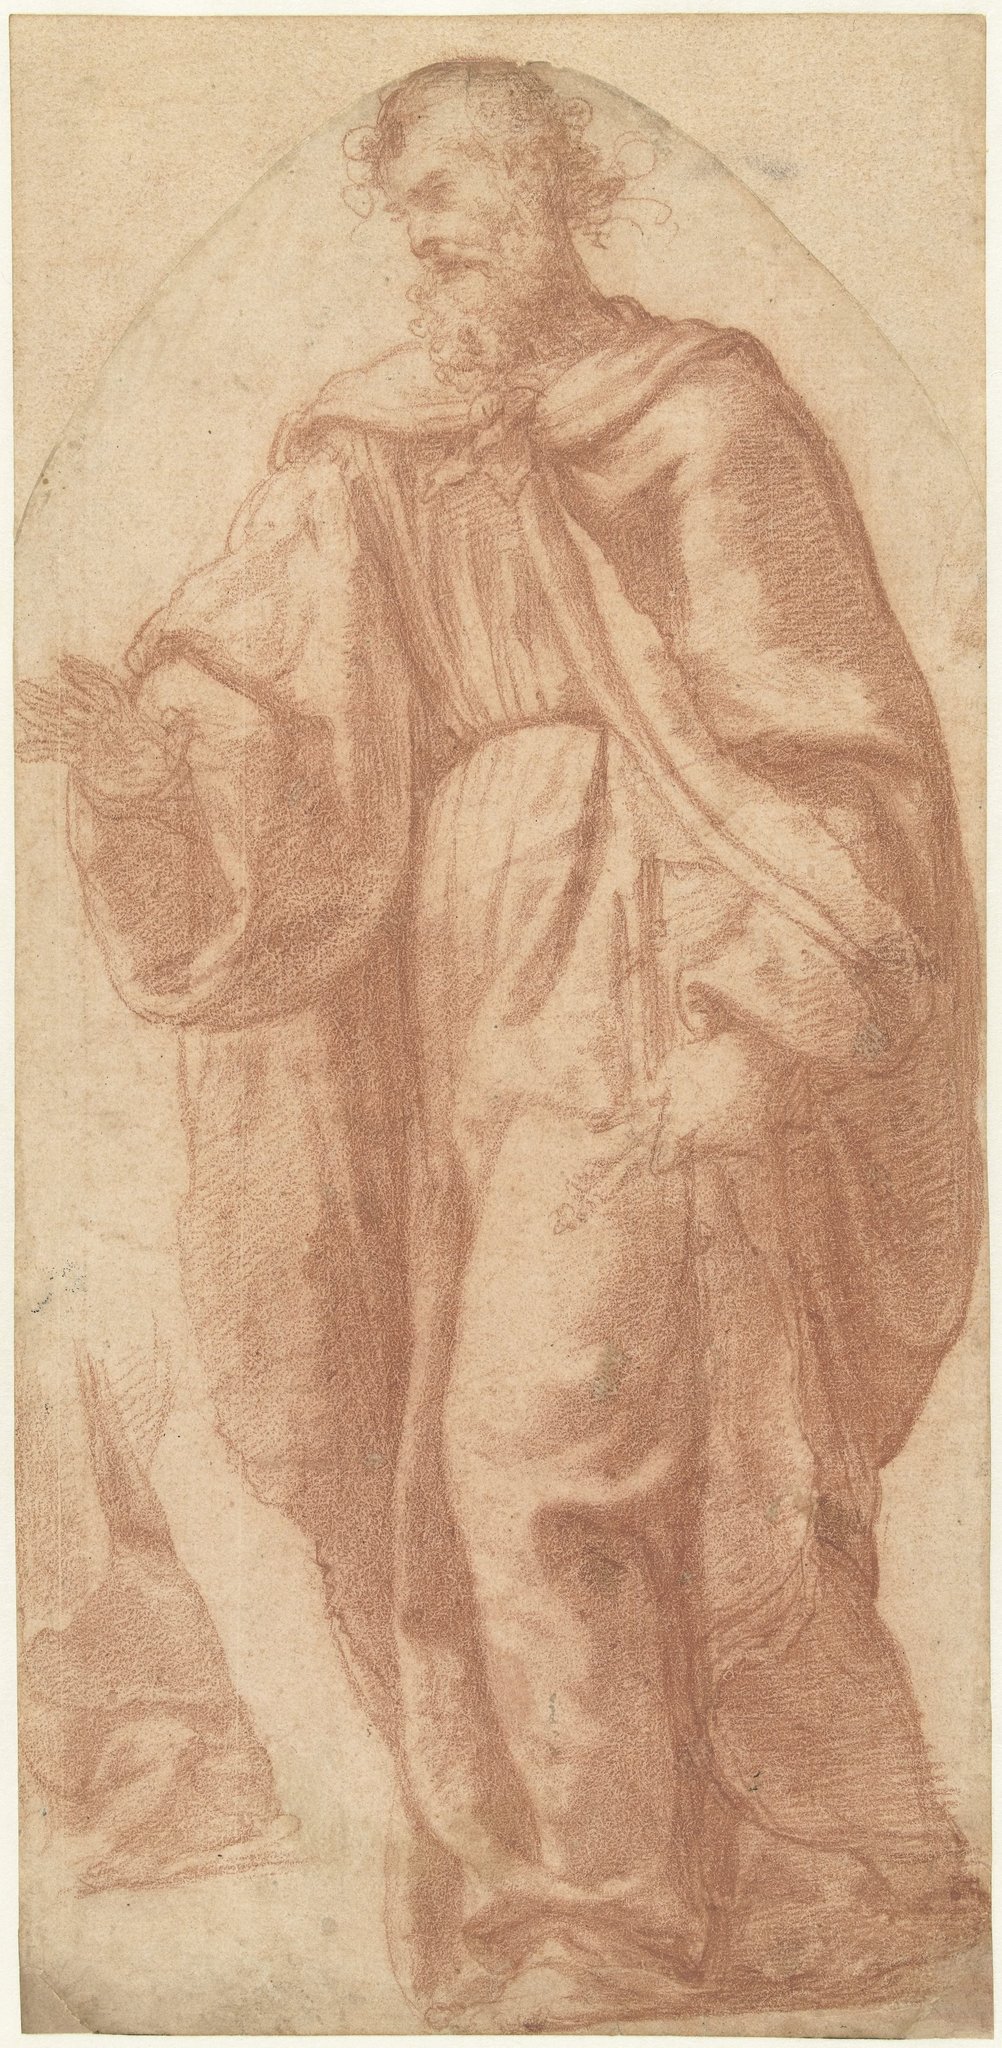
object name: drawing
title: Staande heilige met een boek en sleutel in de hand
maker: jacopo confortini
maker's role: draughtsman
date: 1617-1650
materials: chalk, paper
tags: standing figure, male saints (with name)